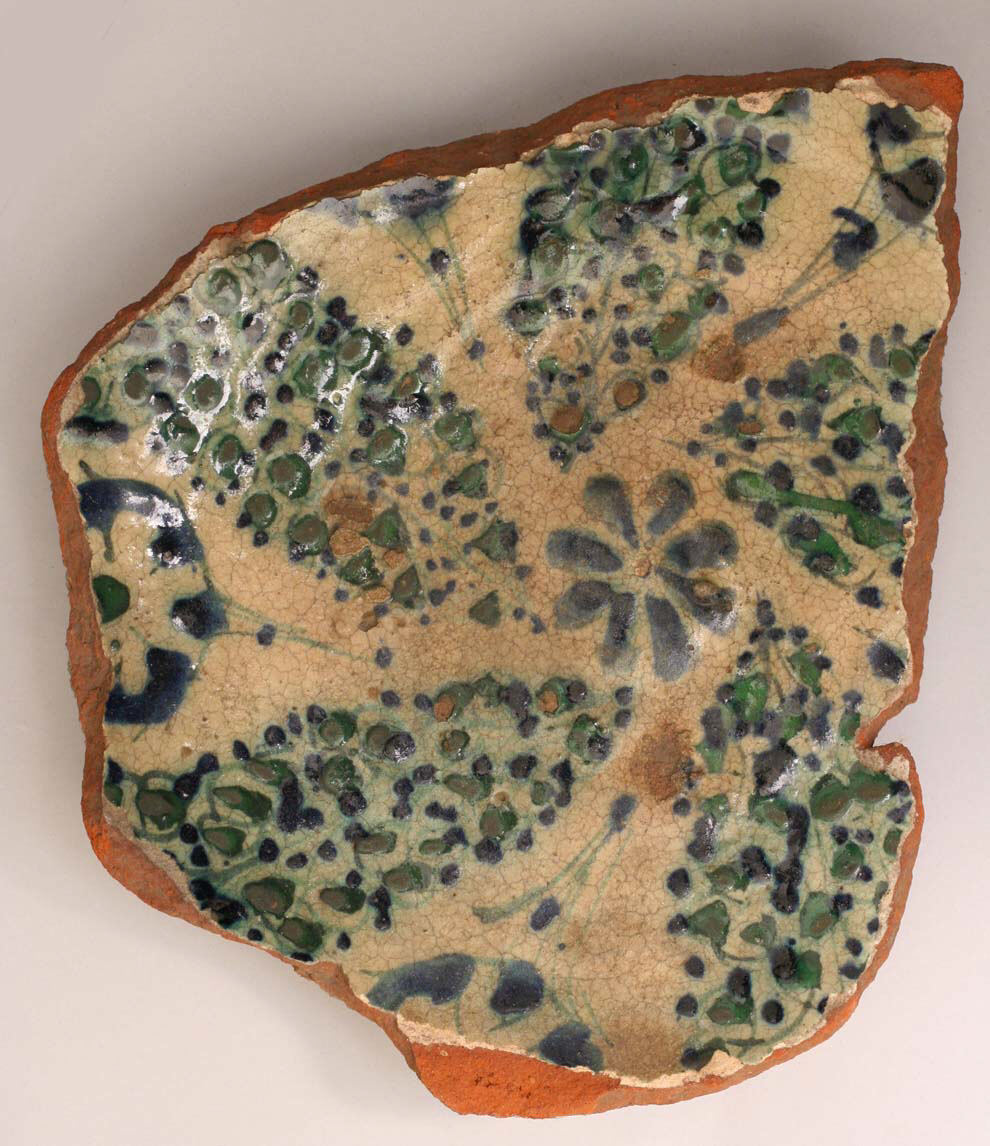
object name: ceramic fragment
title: Fragment of a Bowl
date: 1401-1500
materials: earthenware, glaze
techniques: underglaze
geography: egypt